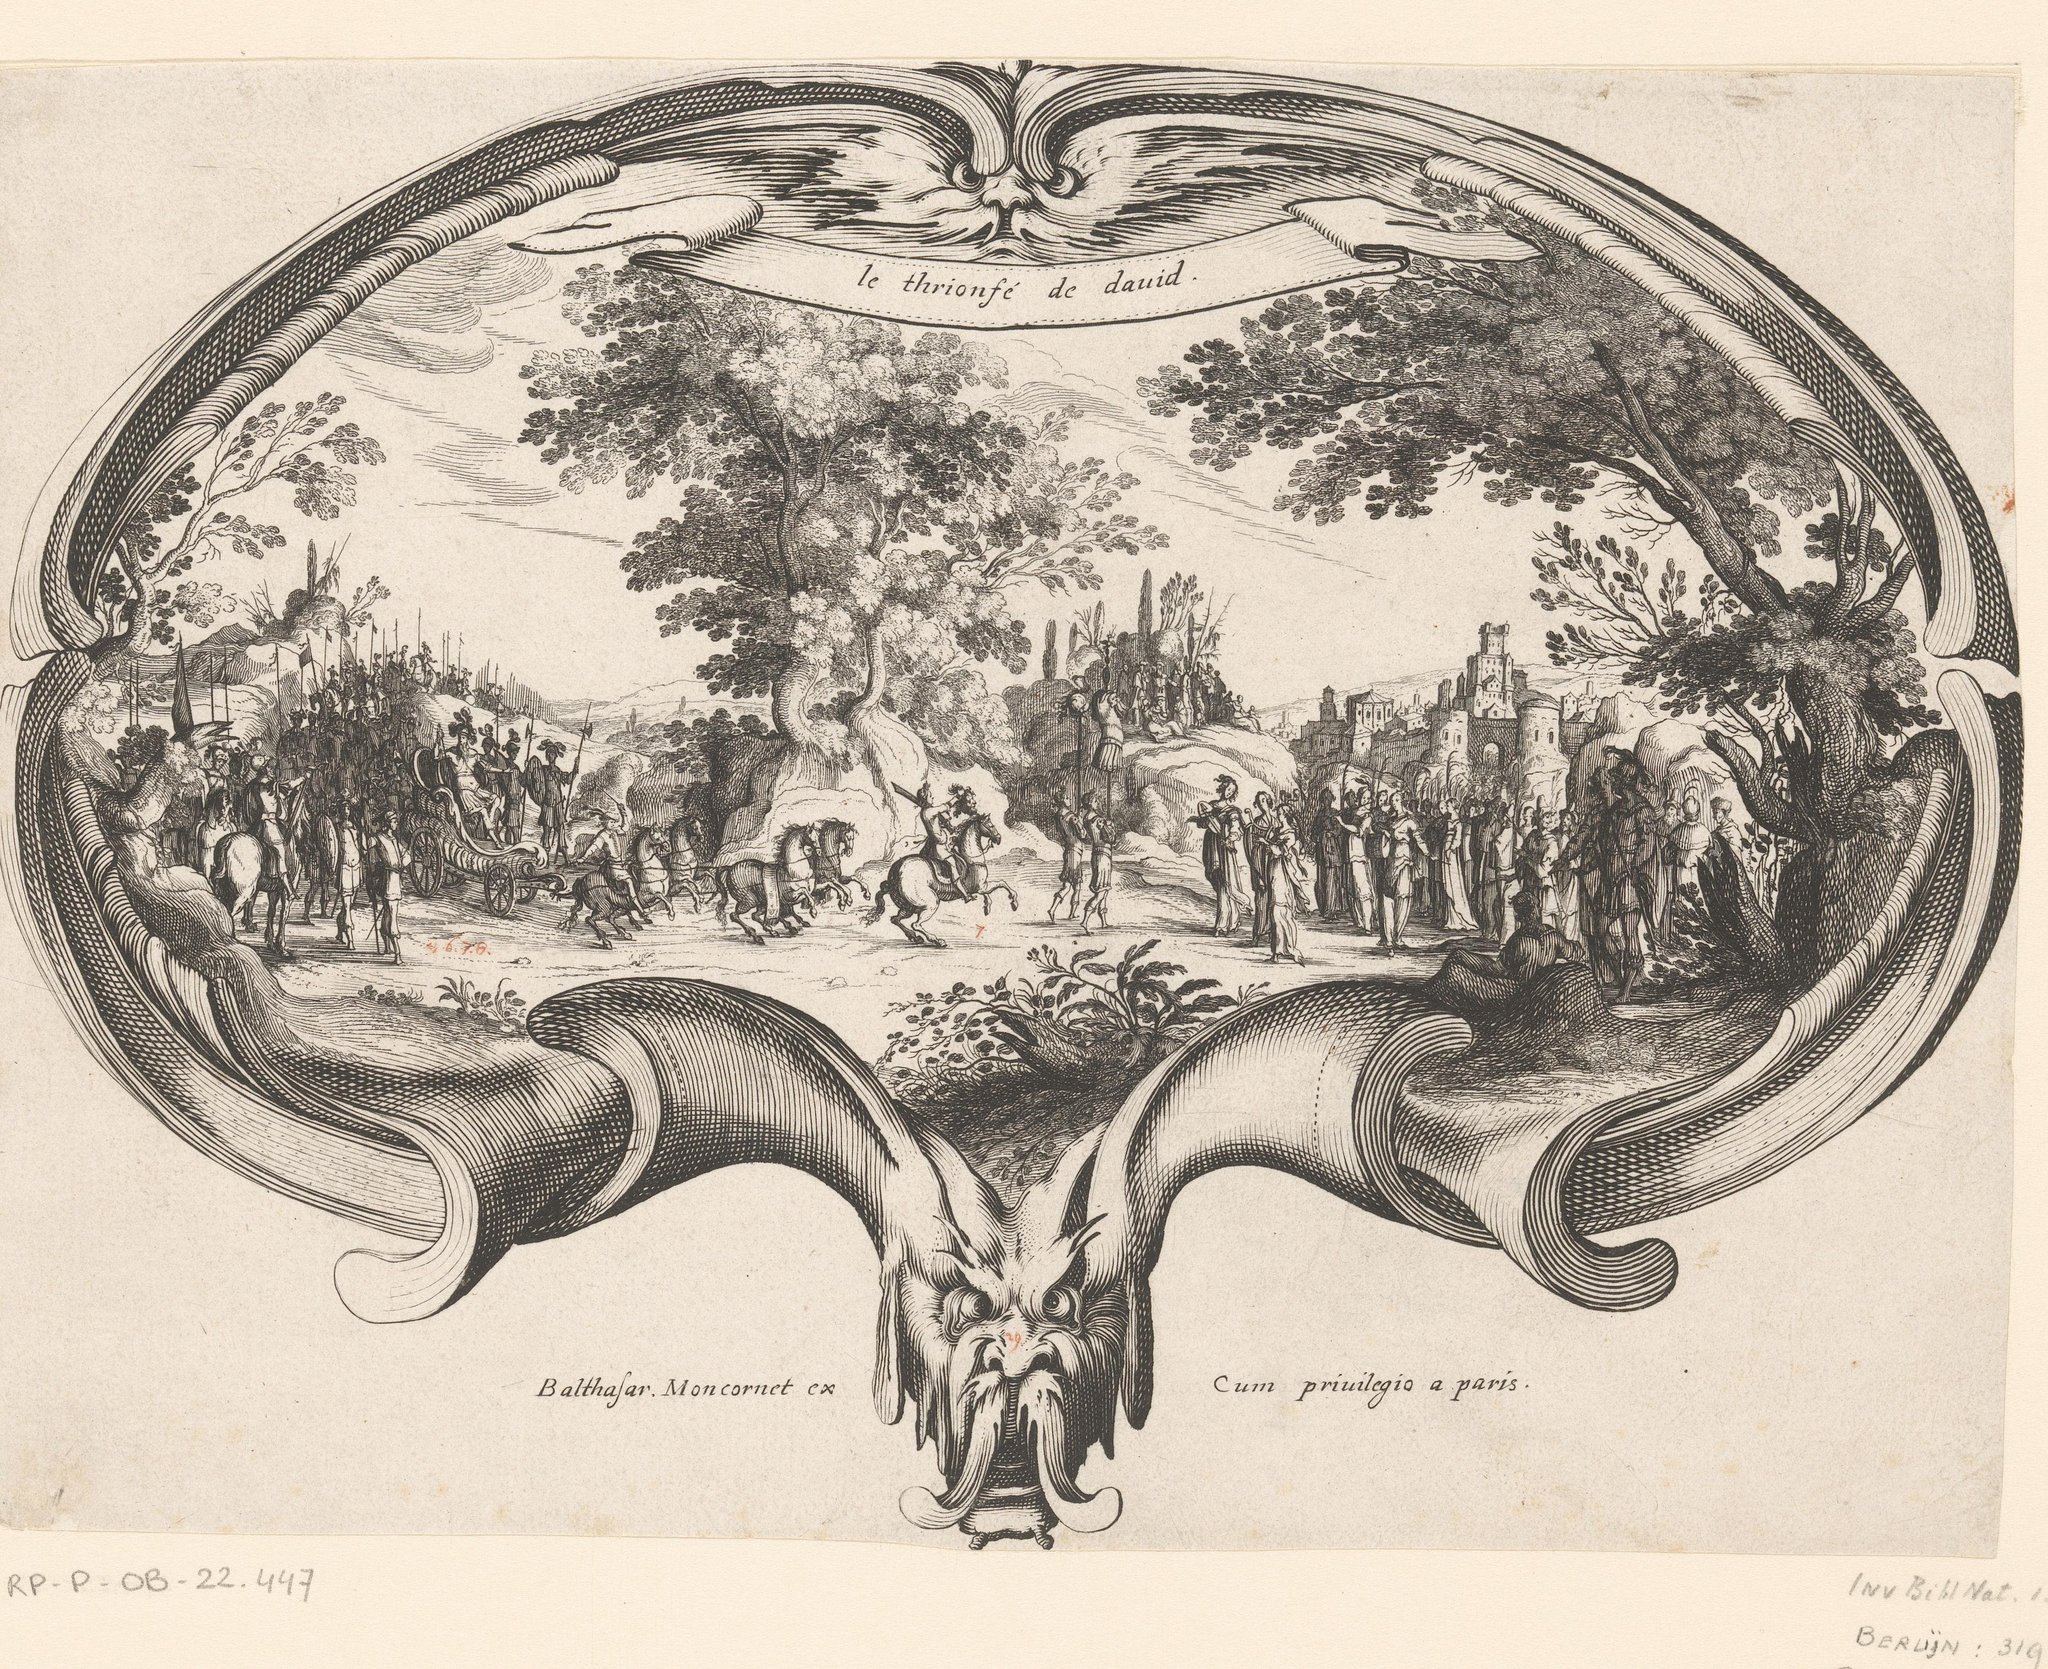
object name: print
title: Triomf van David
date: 1640-1668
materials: paper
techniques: etching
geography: paris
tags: david's triumph: the women of israel come out to welcome david, singing, dancing, and playing tambourines and lyres; david holding the head of goliath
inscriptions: collector's mark: Lugt 240, number: ‘[.]678 / 7’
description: Cartouche met masker en een scène van de triomftocht van David. In het midden rijdt David op een paard met het hoofd van Goliath. Voor hem lopen twee mannen met het lichaam en de helm van Goliath op stokken richting een groep musicerende en dansende vrouwen. Achter David volgt een stoet met voorop koning Saul in een rijtuig getrokken door paarden.